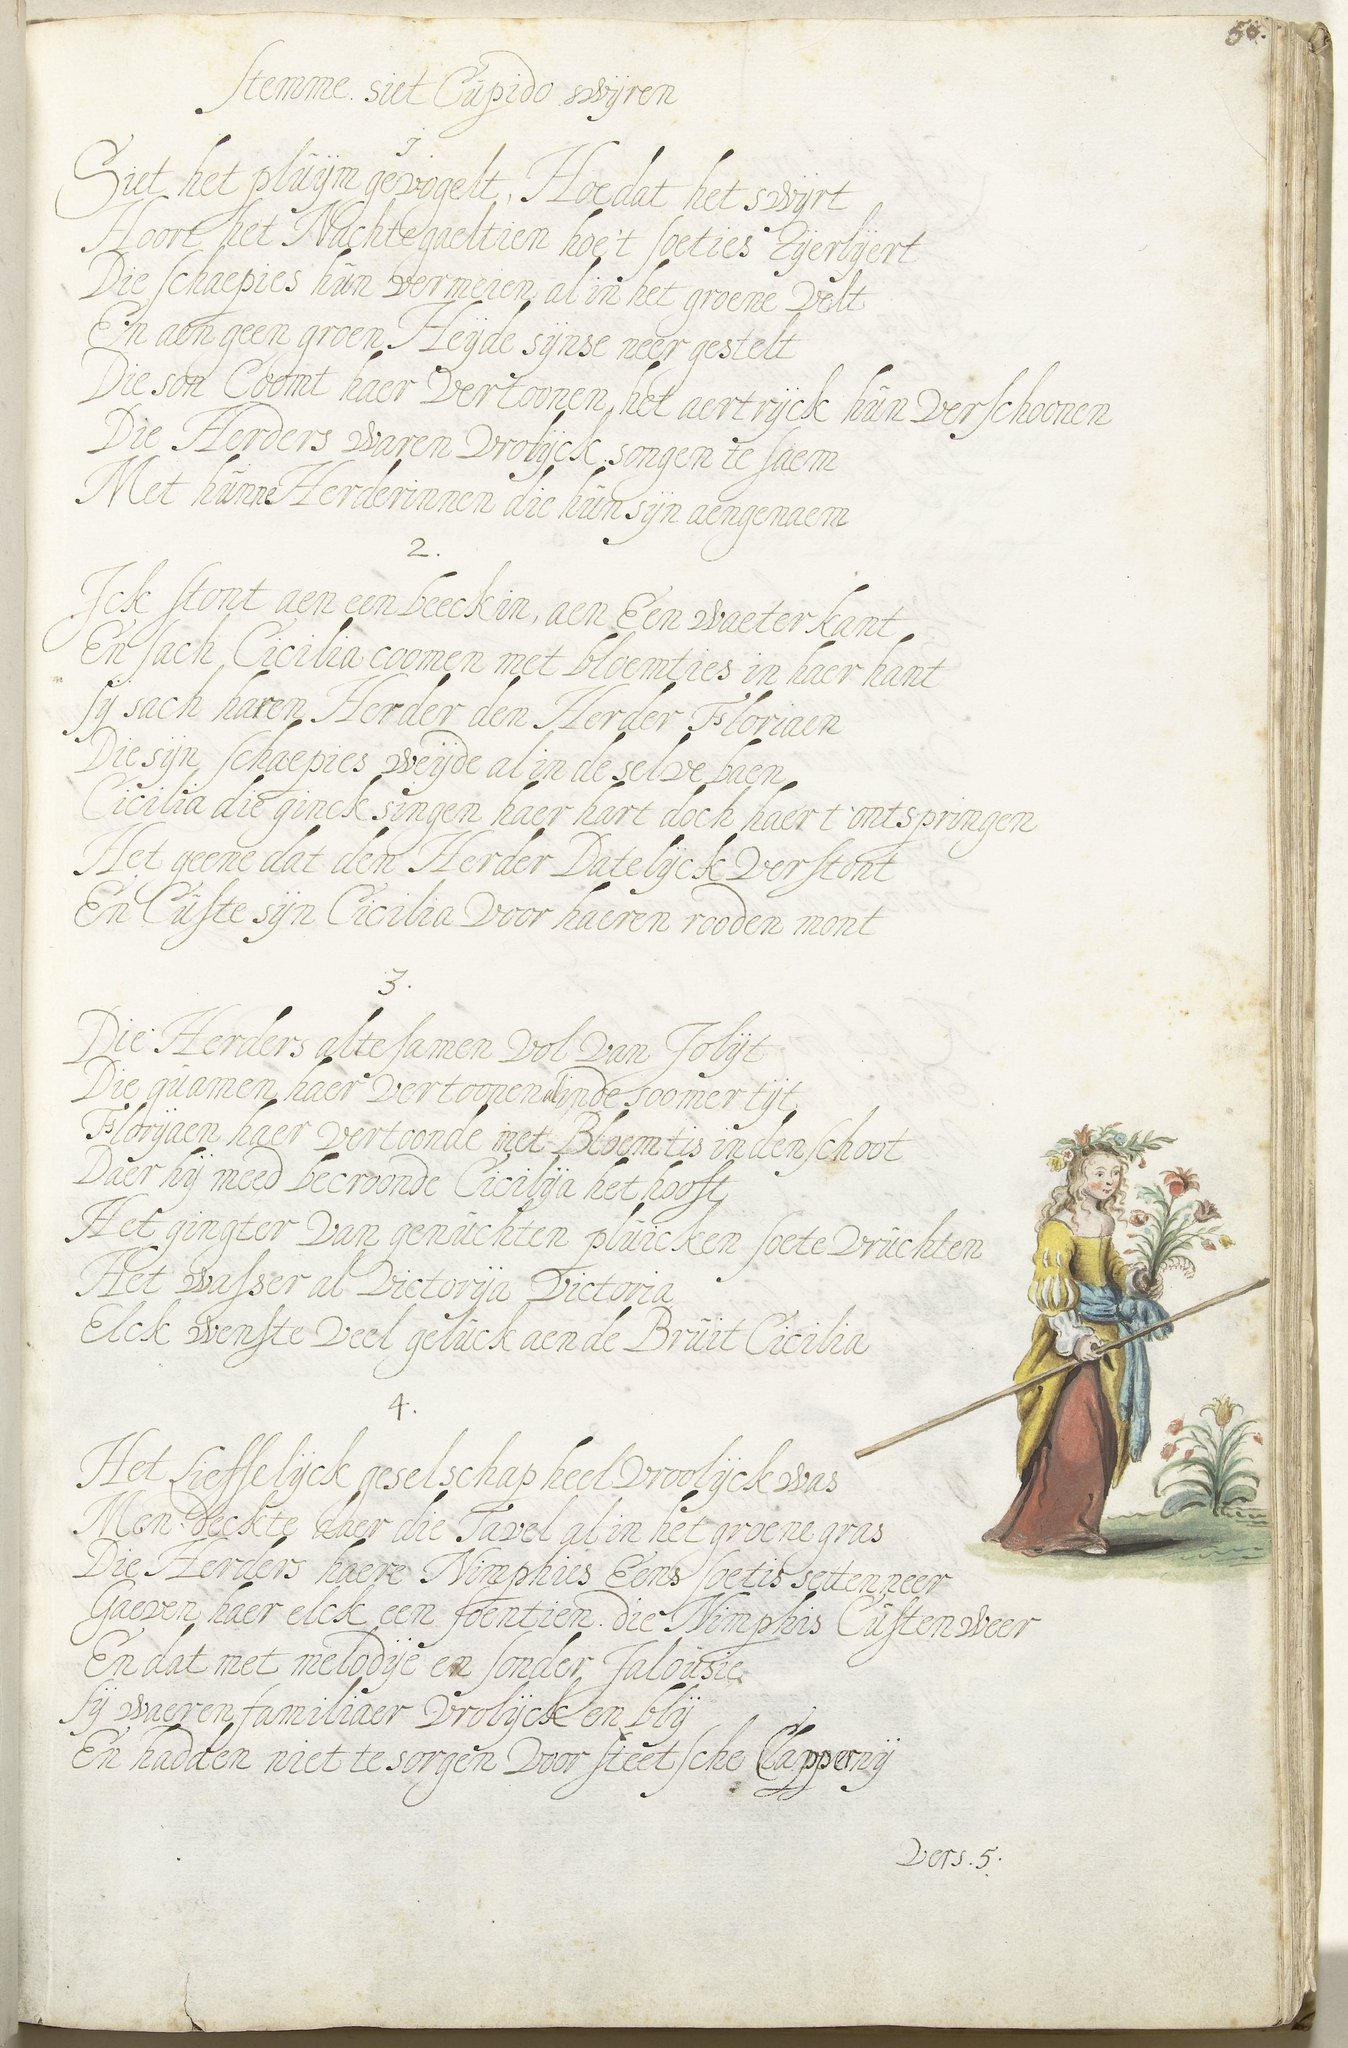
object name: calligraphy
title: Cicilia met bloemen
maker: gesina ter borch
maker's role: draughtsman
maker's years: 1633-1690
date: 1654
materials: ink, paper, watercolor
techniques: brush, calligraphy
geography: zwolle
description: Staande herderin naast gedicht dat het contrast beschrijft tussen de liefde van Cicilia en Floriaen en die van Clorinde en de herder-verteller; op de melodie van Siet Cupido swijren.